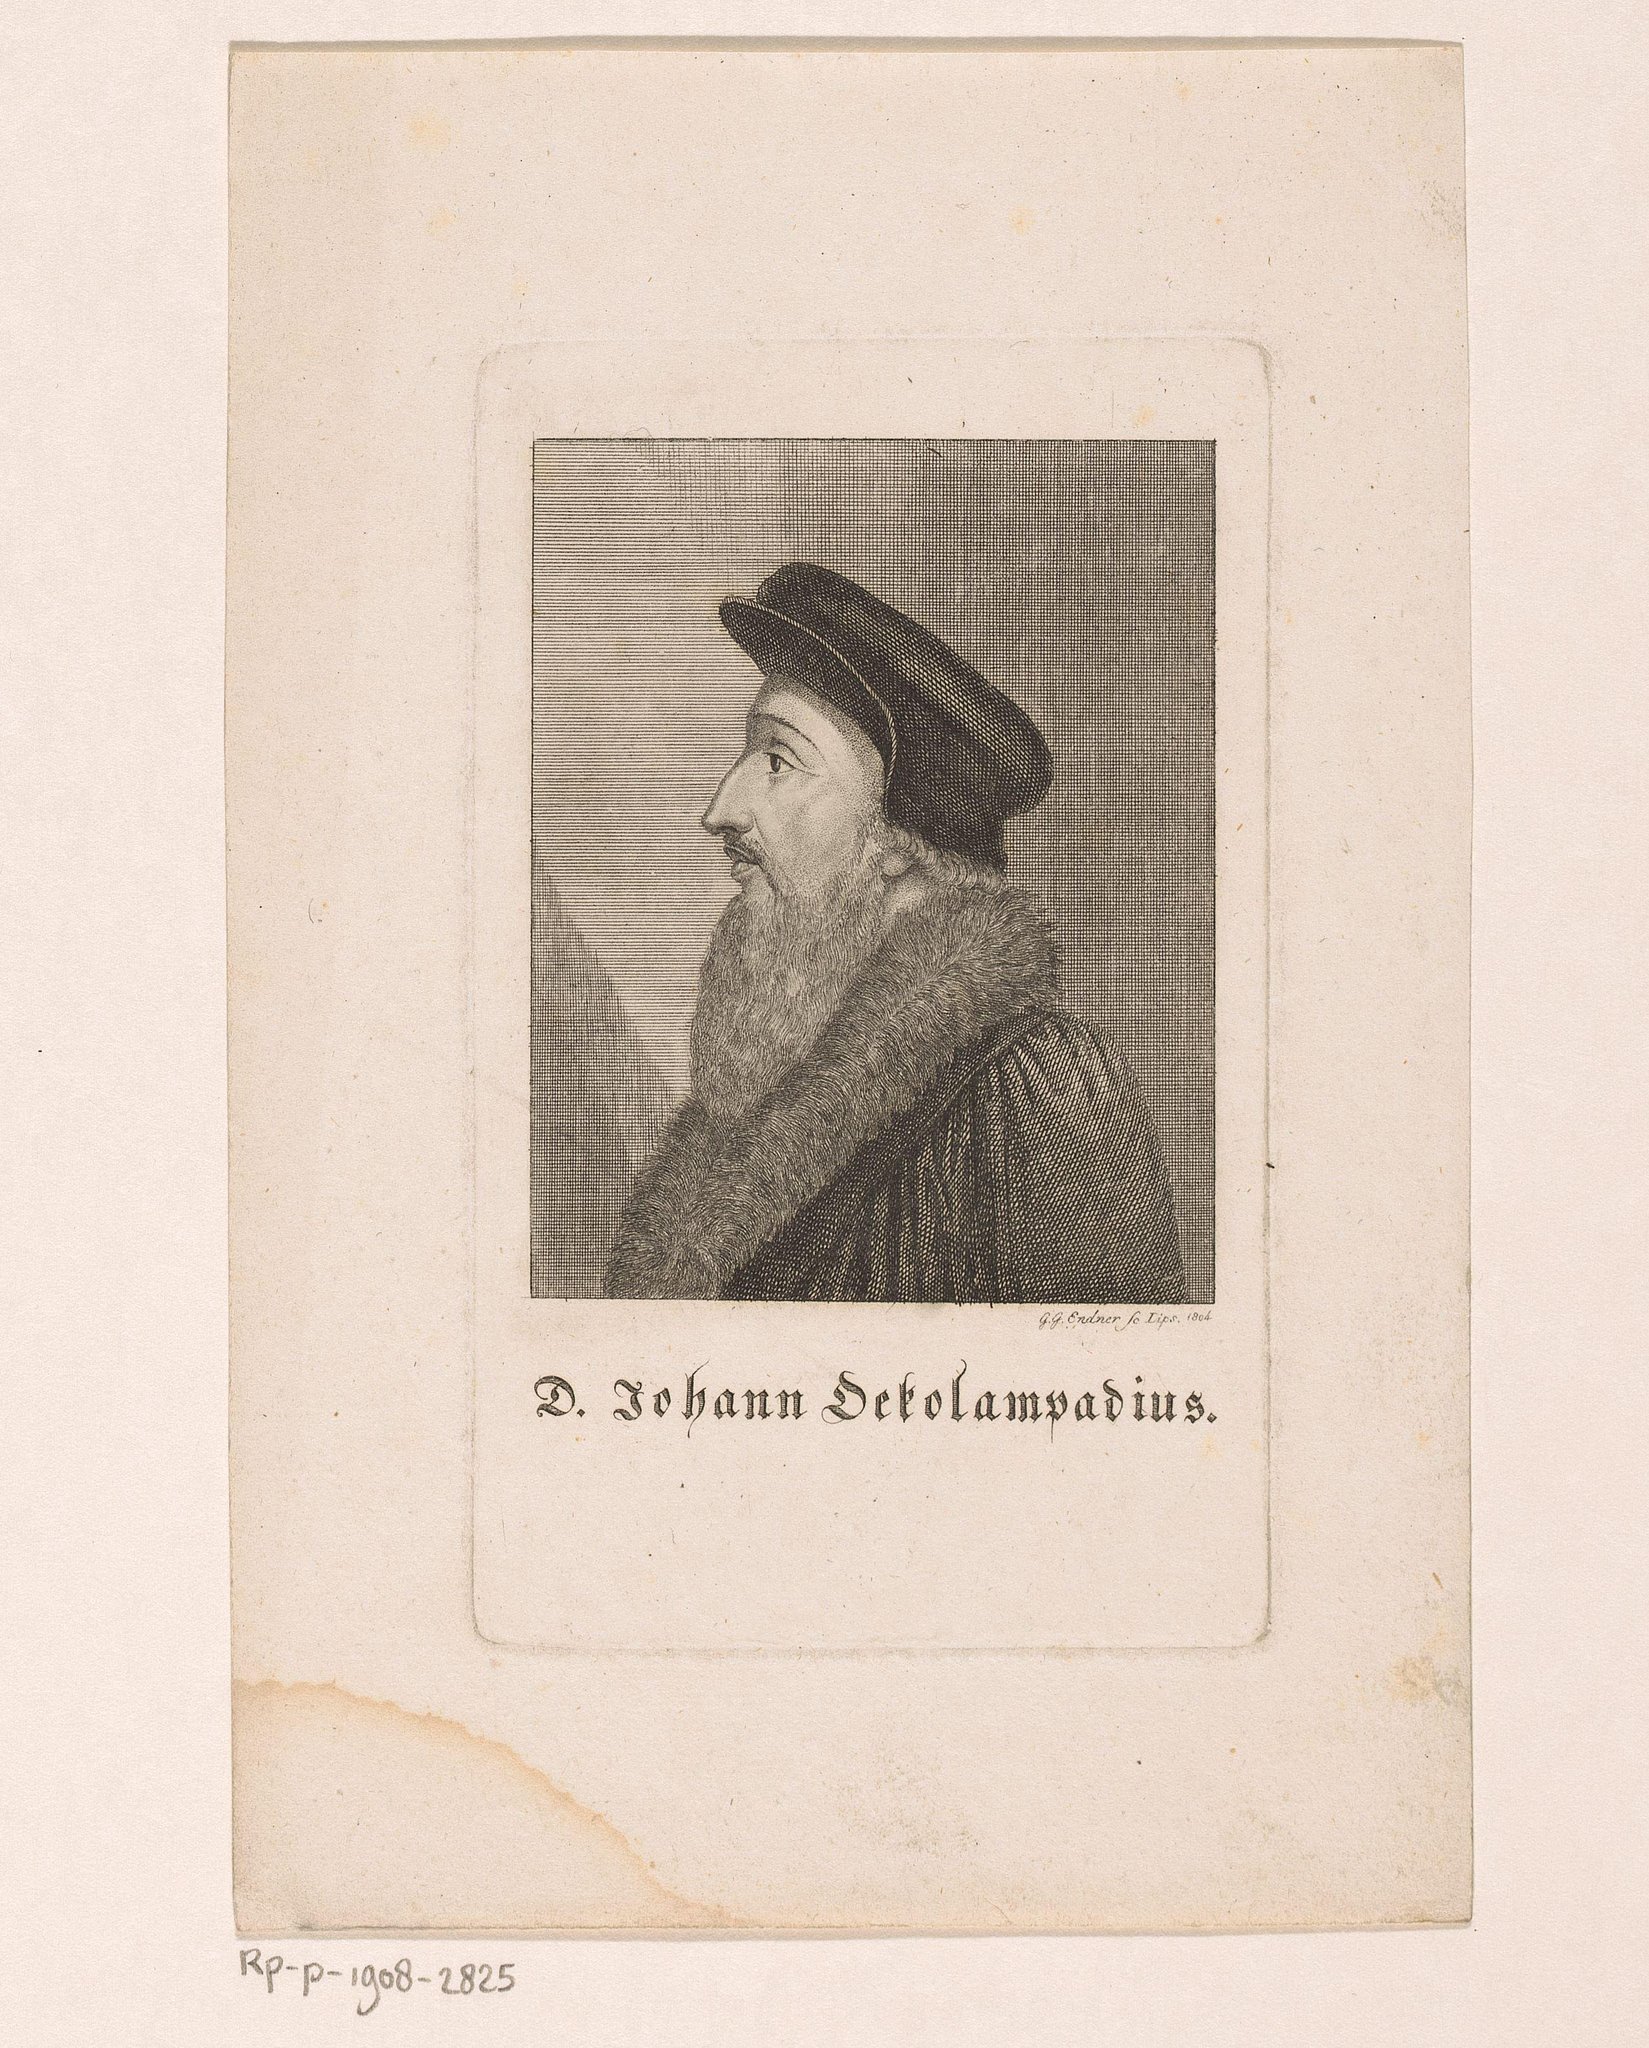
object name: print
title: Portret van Johannes Oecolampadius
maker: gustav georg endner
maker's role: print maker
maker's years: 1754-1824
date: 1804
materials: paper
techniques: engraving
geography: leipzig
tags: historical persons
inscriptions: collector's mark: Lugt 2228